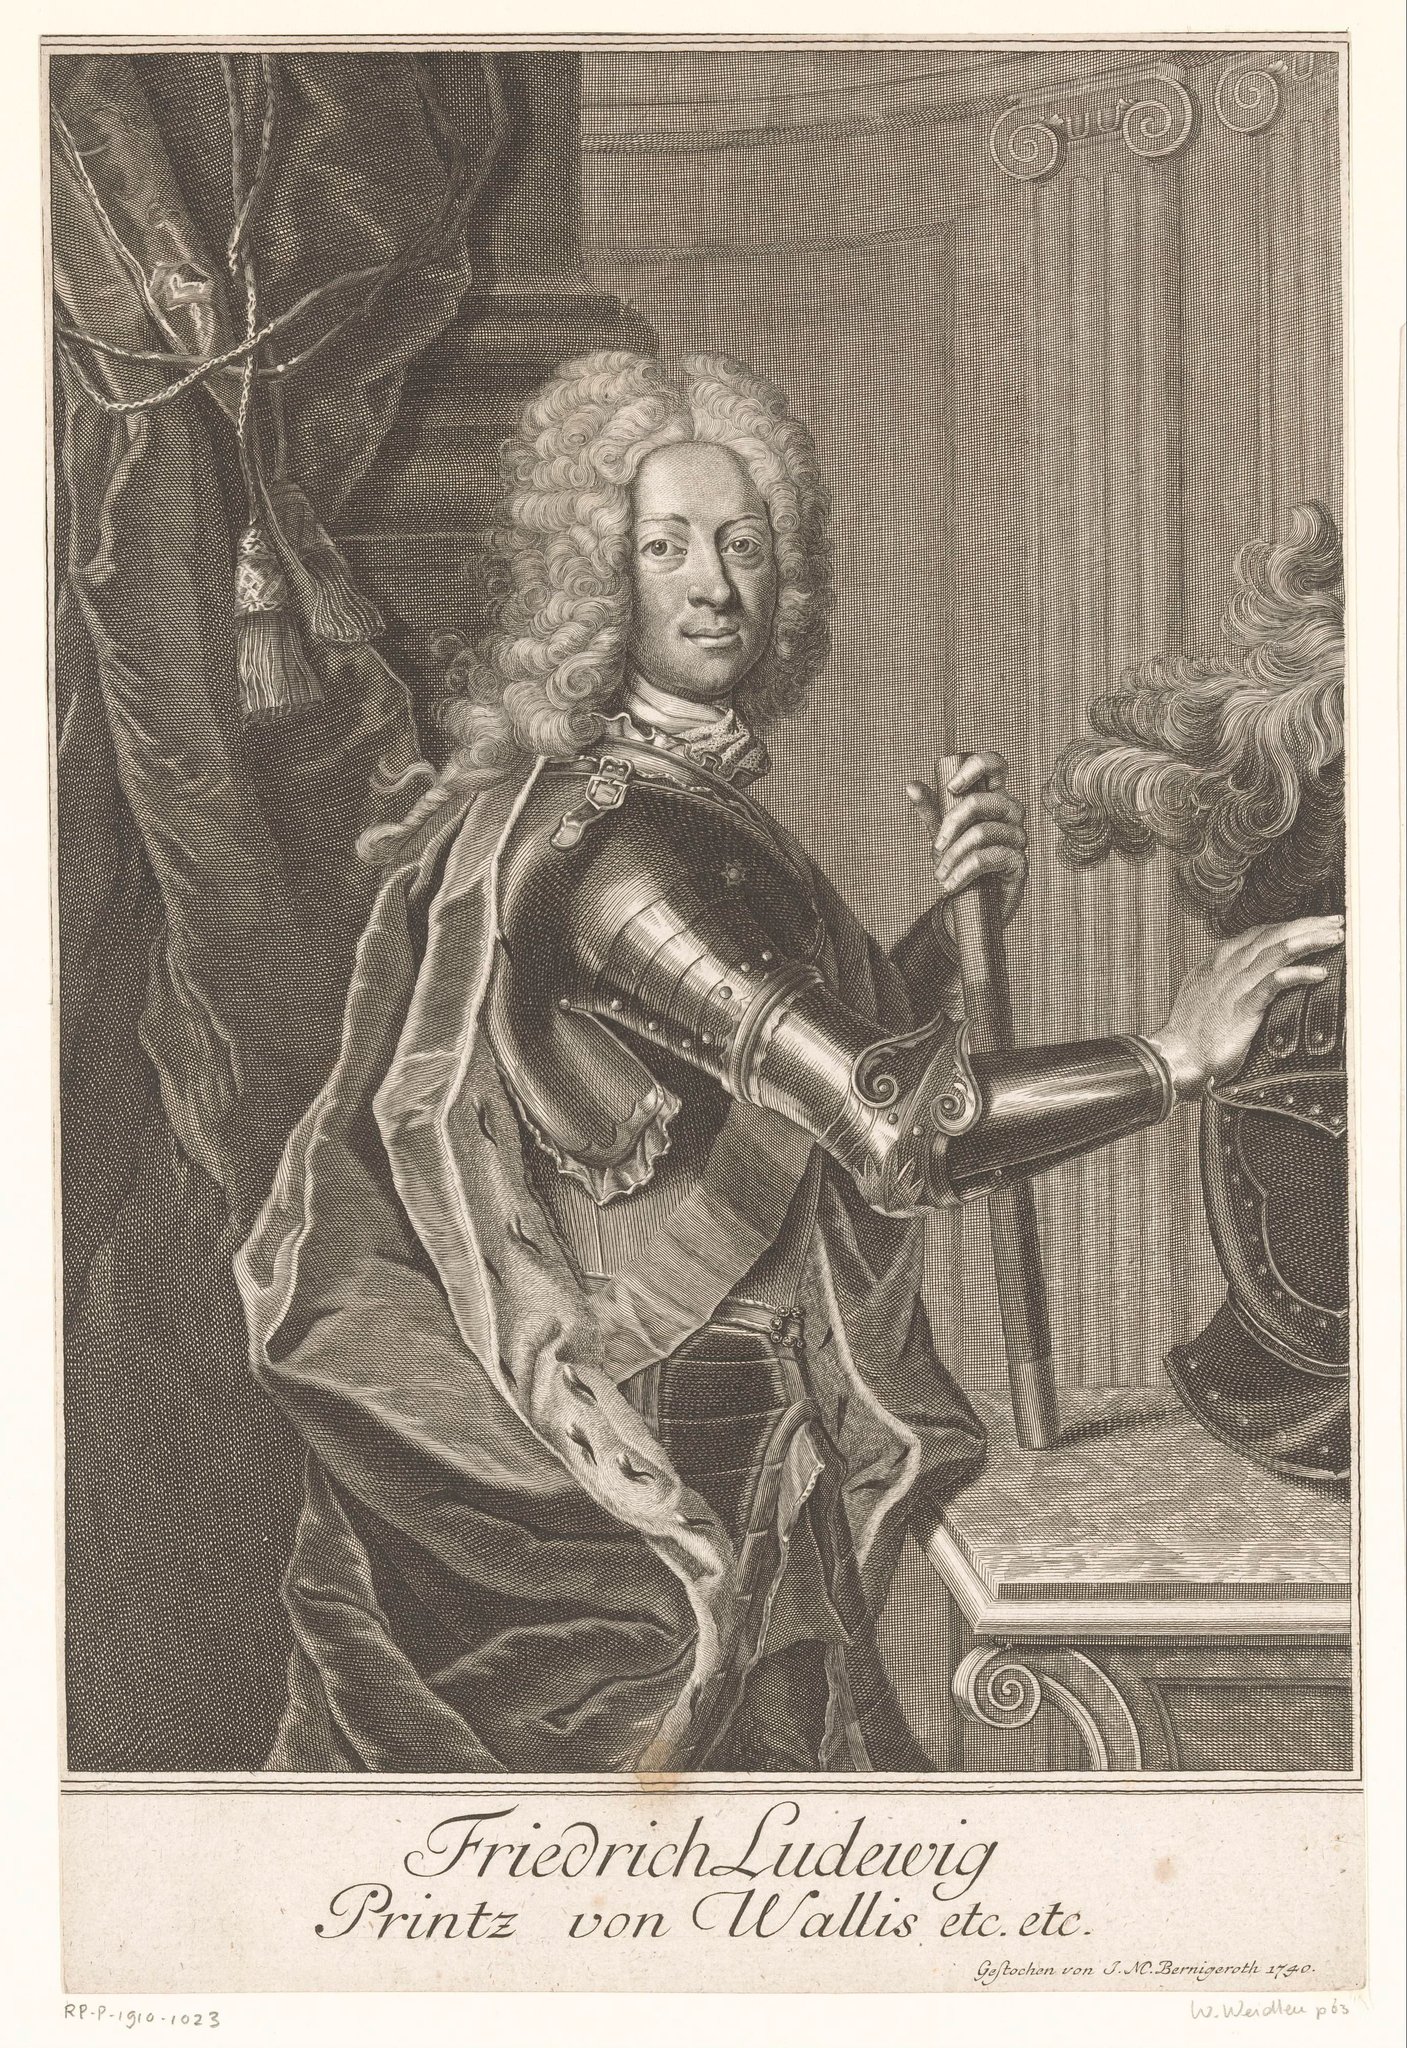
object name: print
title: Portret van Frederik, prins van Wales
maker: johann martin bernigeroth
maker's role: print maker, publisher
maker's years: 1713-1767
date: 1740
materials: paper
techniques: engraving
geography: leipzig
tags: frederik (prins van wales), armour, historical persons, royal mantle (symbol of sovereignty)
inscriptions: collector's mark: Lugt 2228